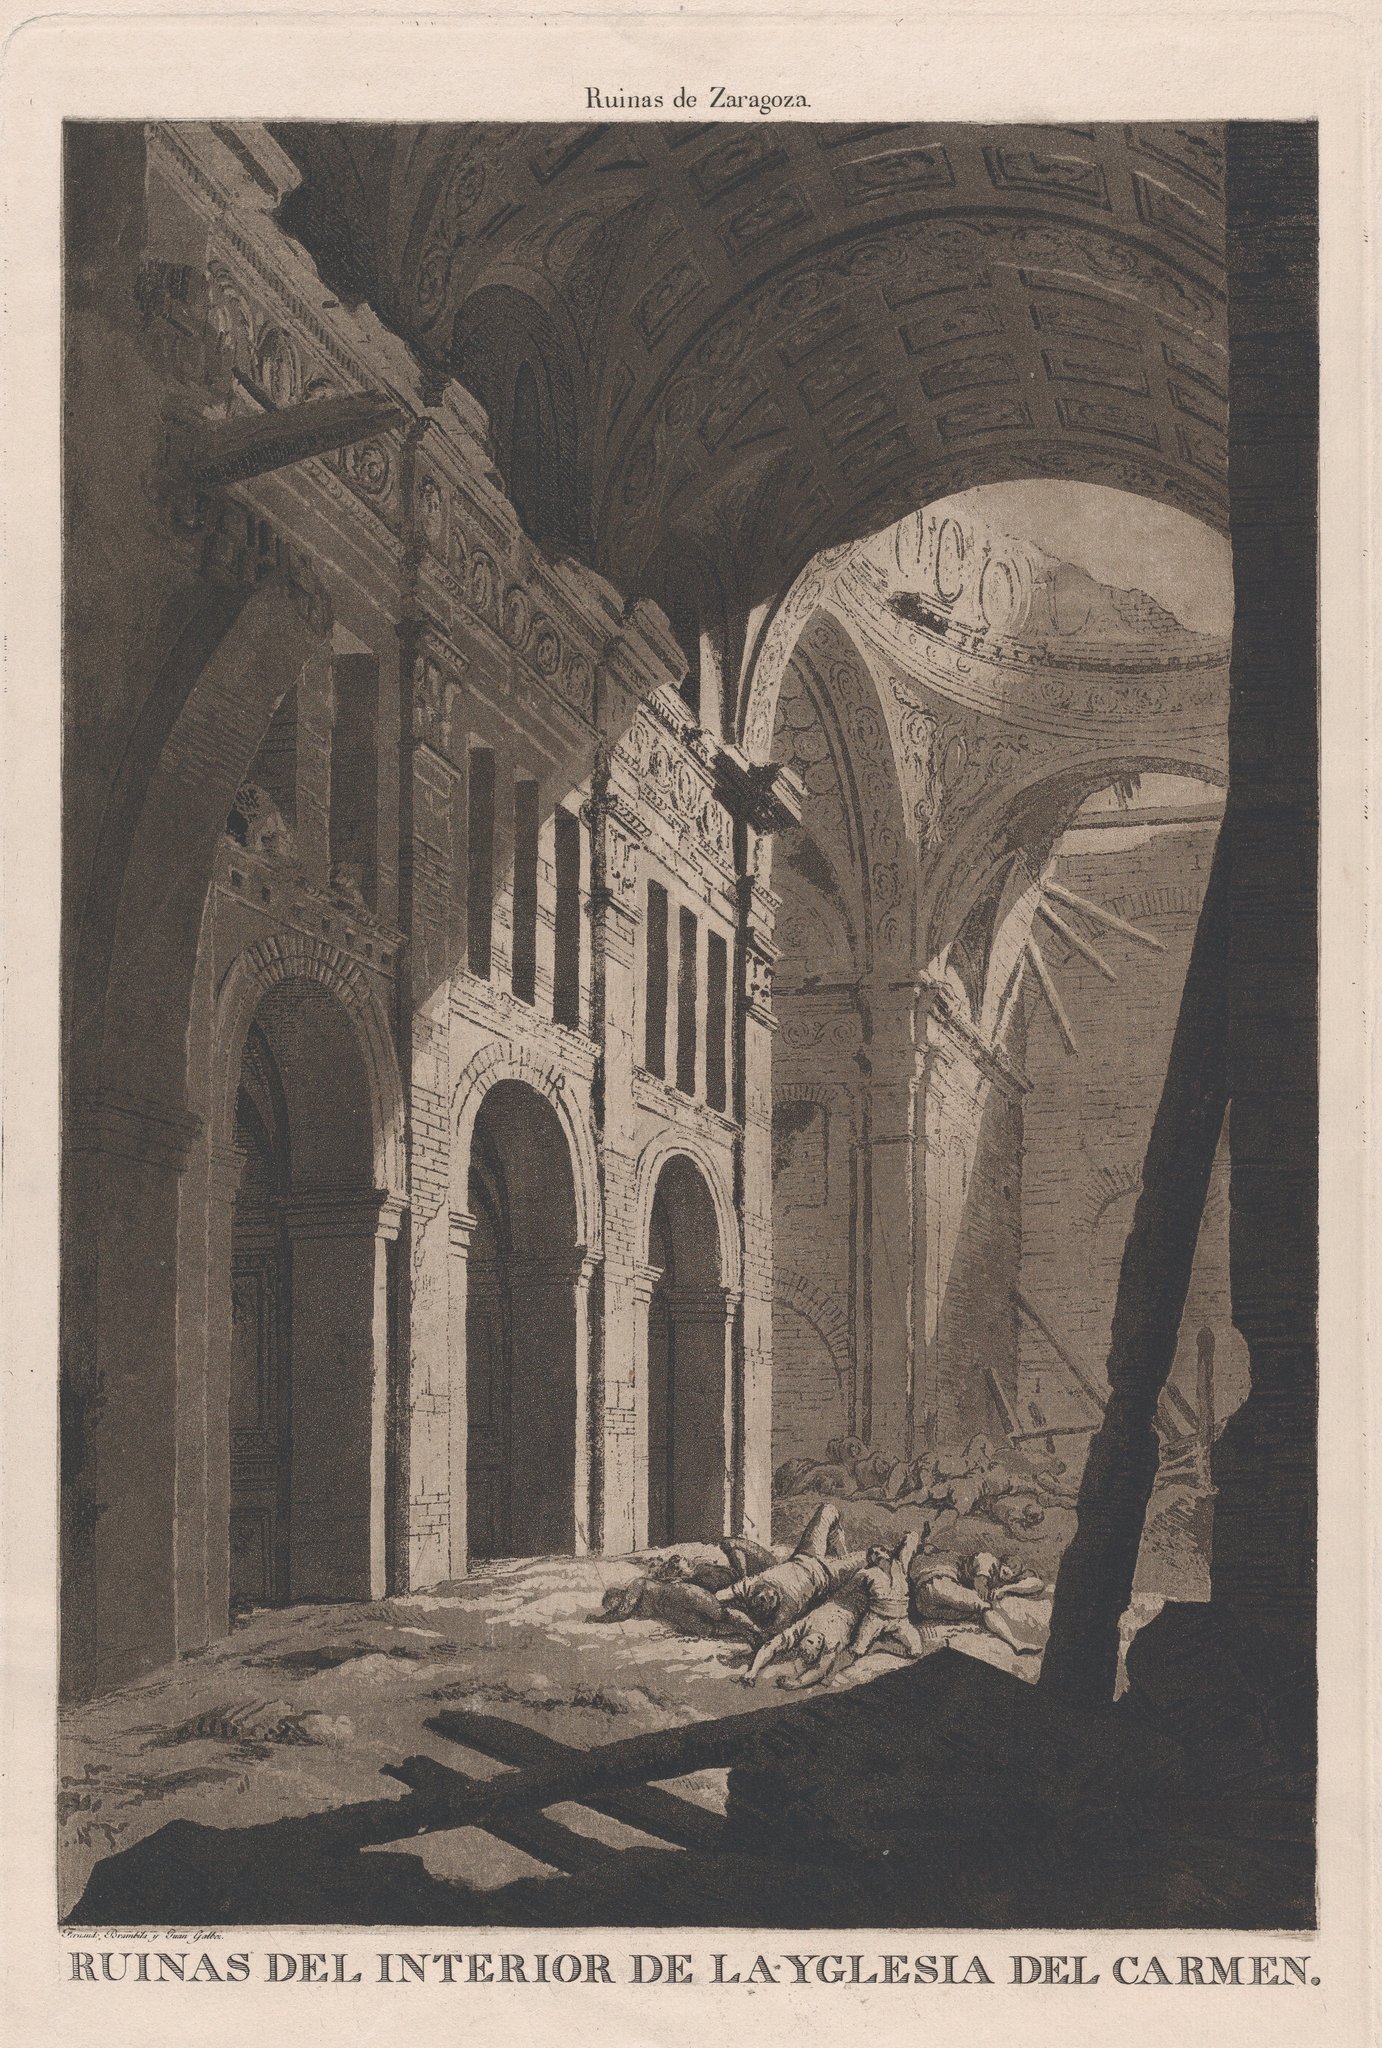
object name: print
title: View of the ruins of the interior of the Church of Nuestra Senora del Carmen in Saragossa bombed by the invading French army during the Napoleonic war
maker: fernando brambila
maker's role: artist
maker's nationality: spanish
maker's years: 1763-1834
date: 1808-1814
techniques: aquatint, etching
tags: interiors,churches,ruins